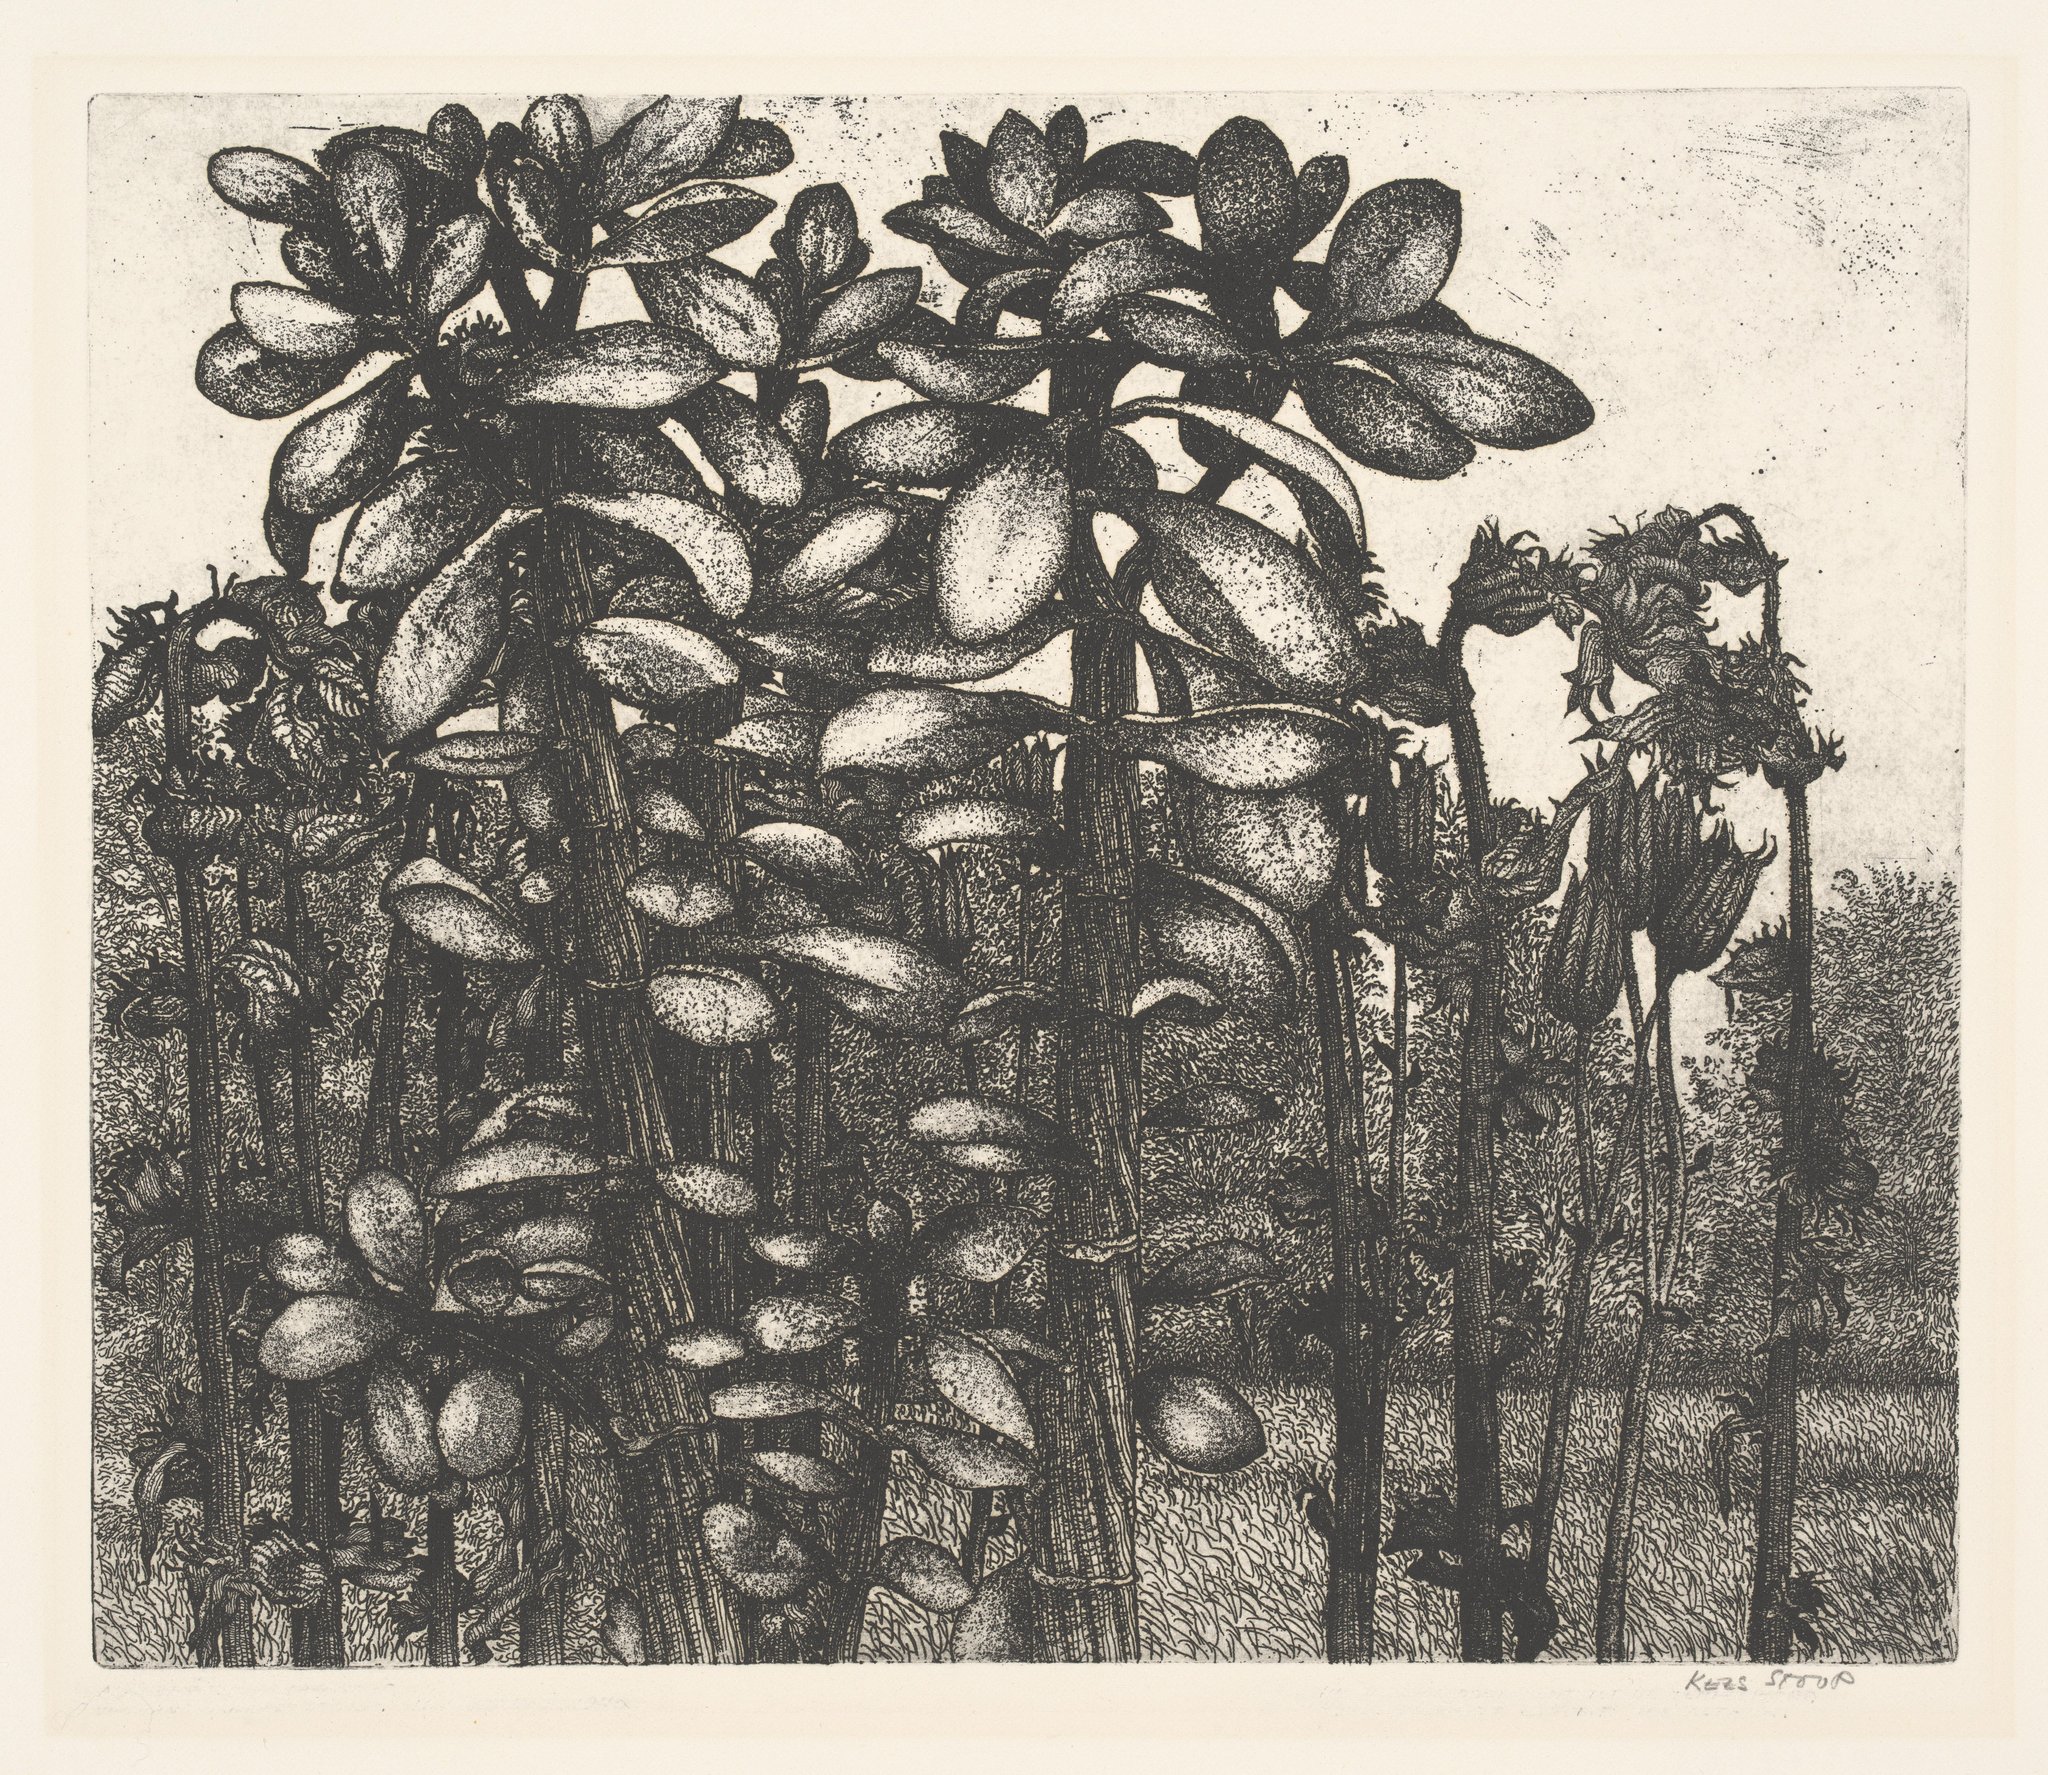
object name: print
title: Plant met lepelvormige bladeren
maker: kees stoop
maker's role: draughtsman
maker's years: 1929-2019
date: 1970-1971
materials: paper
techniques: etching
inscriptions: date: ‘'70 - '71’, signature: ‘KEES STOOP’